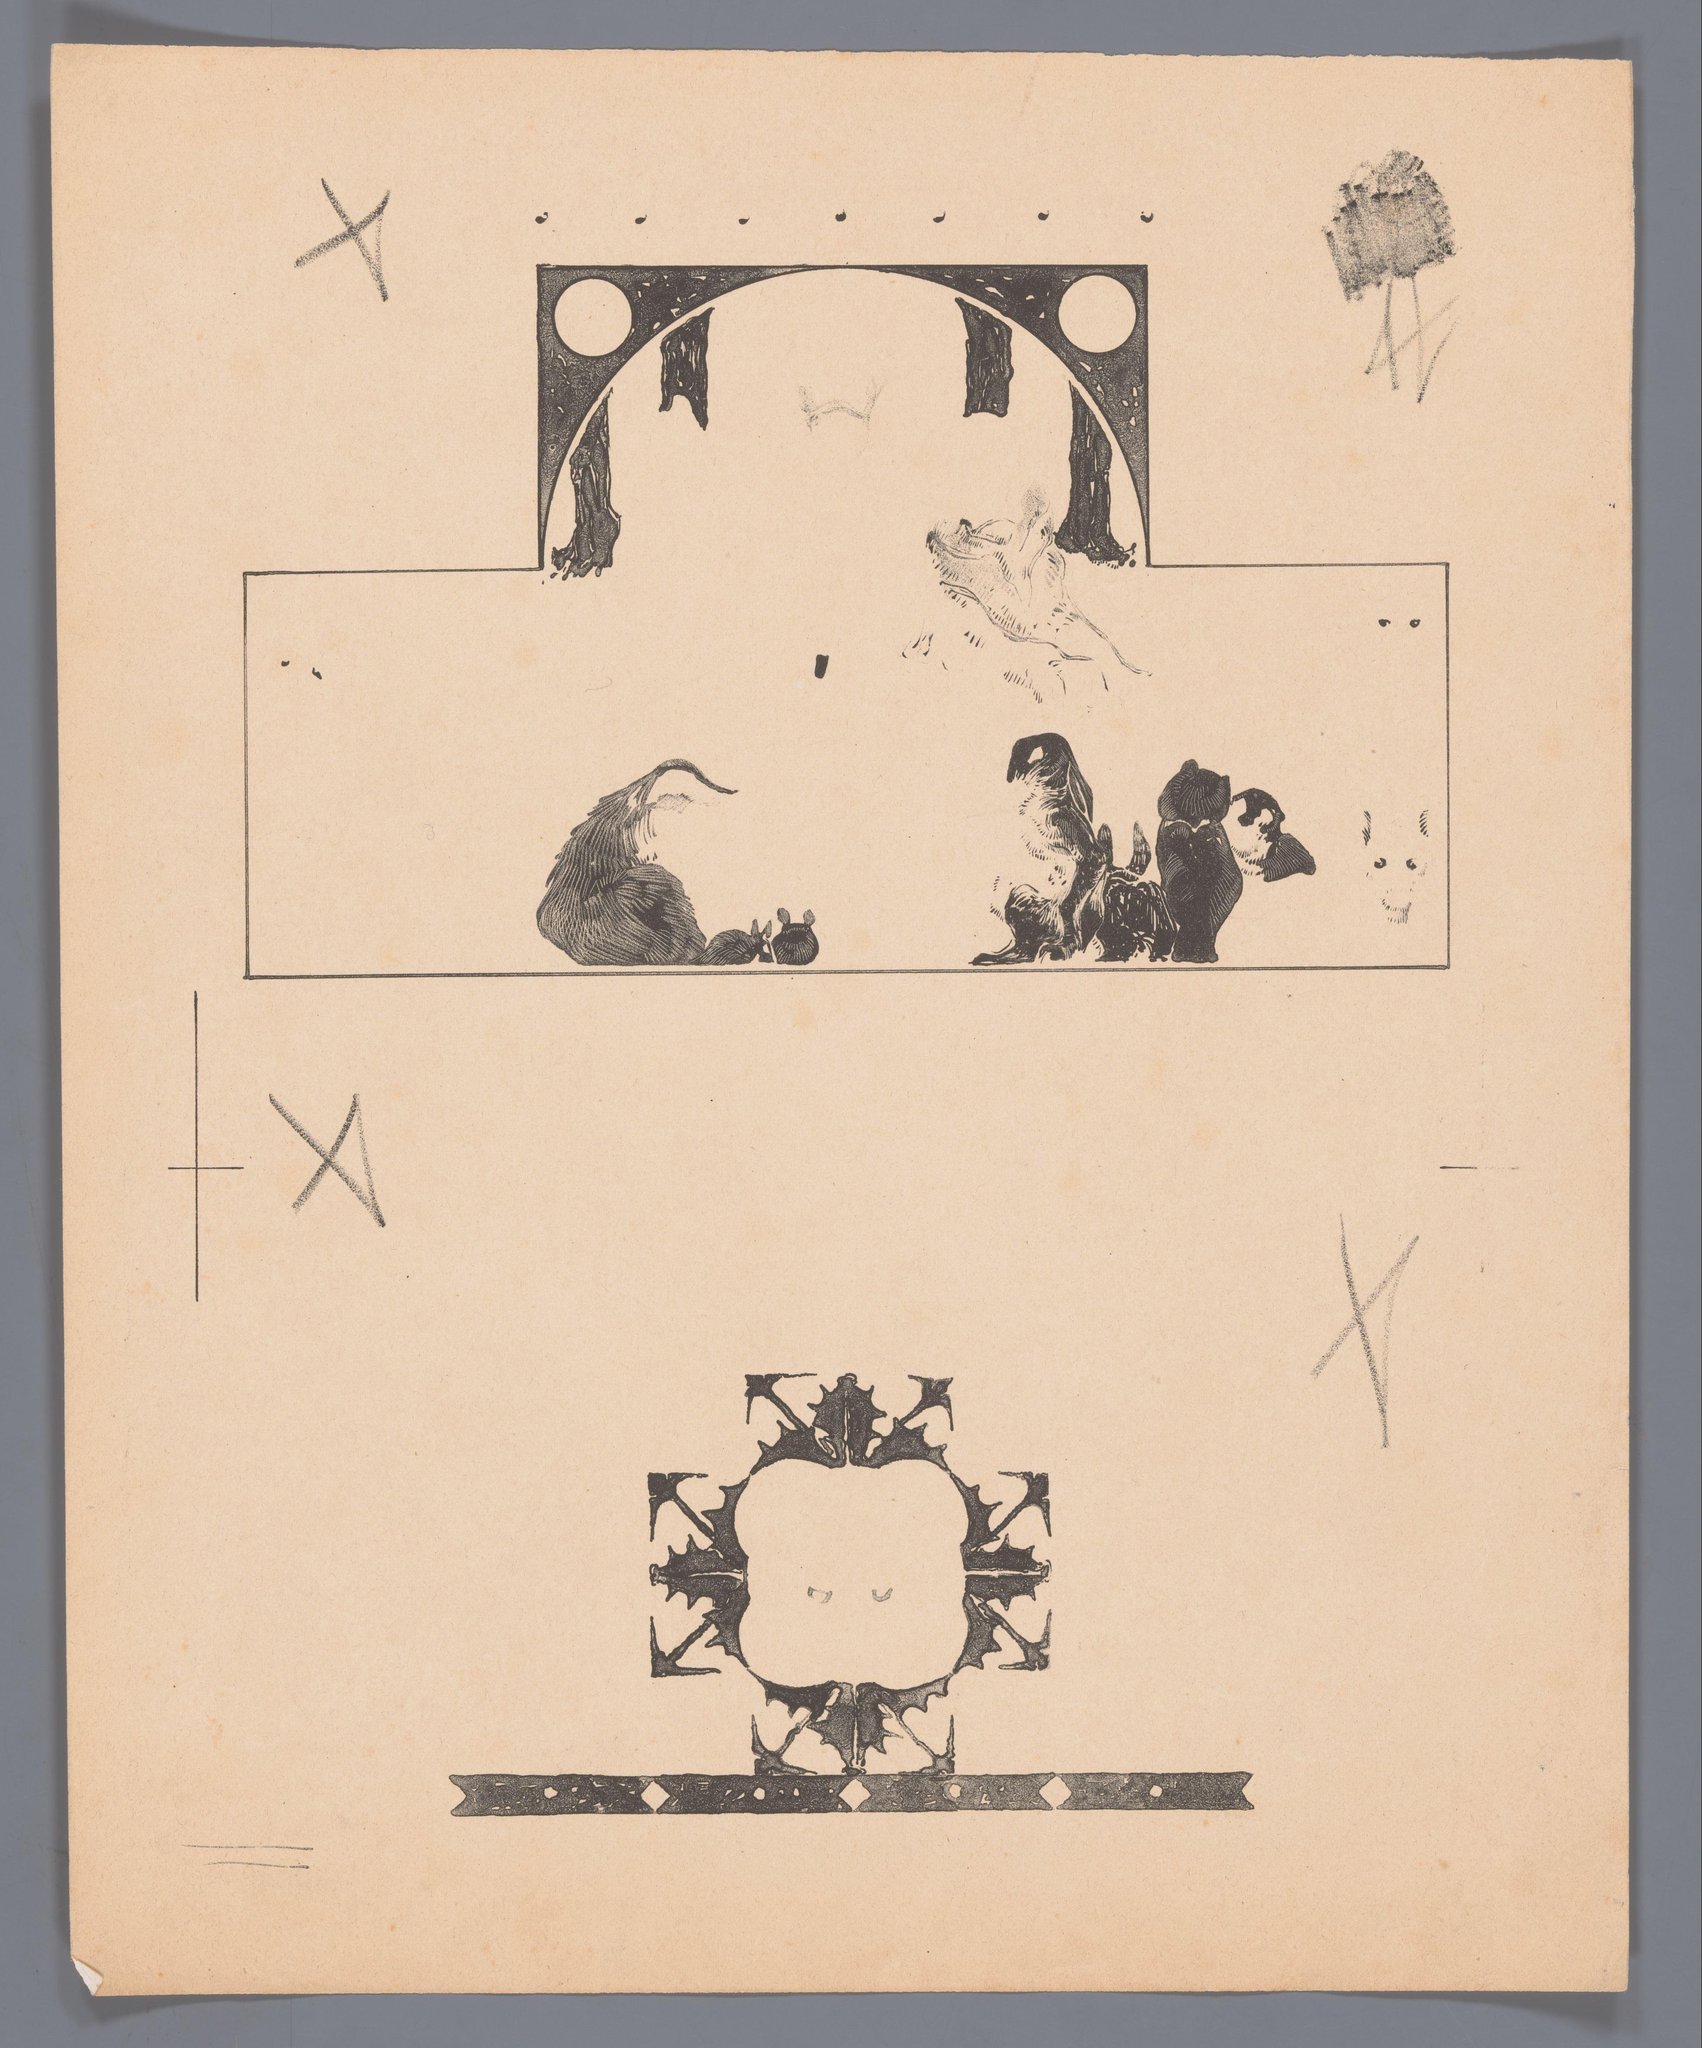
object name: print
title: Ontwerp voor titelpagina voor: Stijn Streuvels, Reinaert de Vos, 1910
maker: bernard willem wierink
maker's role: draughtsman, print maker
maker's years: 1856-1939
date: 1910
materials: paper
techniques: lithograph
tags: fable of reynard the fox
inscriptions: collector's mark: Lugt 2228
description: Niet gebruikt ontwerp voor: Streuvels, Stijn (Frank Lateur). Reinaert de Vos naar verschillende uitgaven van het middeleeuwsche epos. Amsterdam: L.J. Veen, 1910.